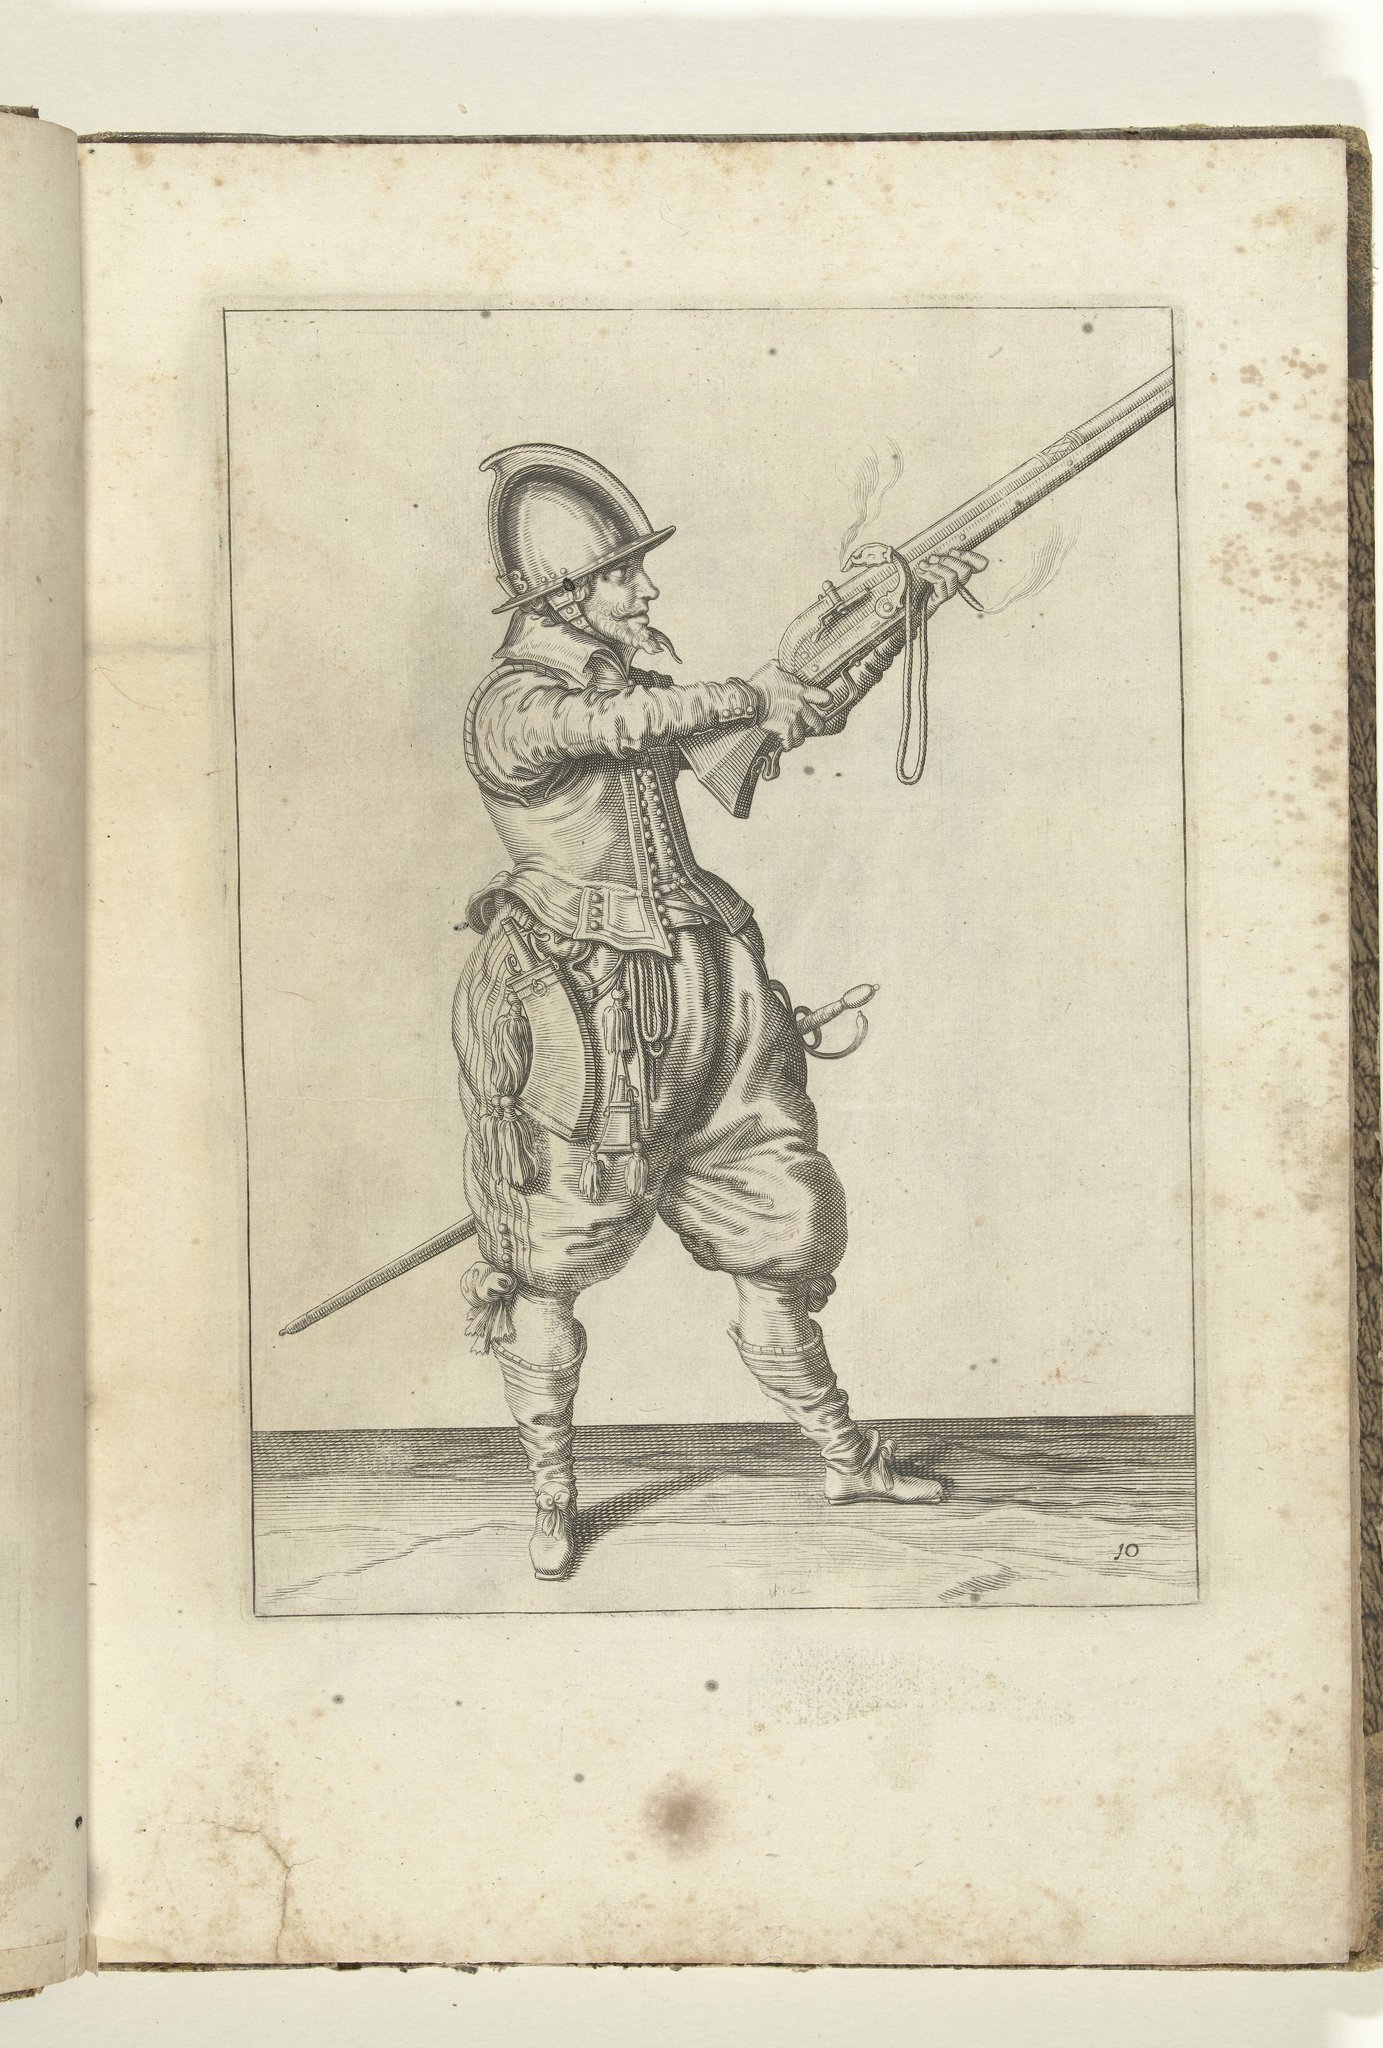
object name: print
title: Soldaat richt de roer met beide handen omhoog (nr. 10), ca. 1600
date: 1597-1608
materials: paper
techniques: engraving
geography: amsterdam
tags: maurice (prince of orange), handling of weapons ~ military training, weapons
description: Een soldaat, ten voeten uit, naar rechts, die een roer (een bepaald type vuurwapen) met beide handen vasthoudt en deze schuin omhoog richt (nr. 10), ca. 1600. Plaat 10 in de instructies voor het hanteren van de roer: Brief enseignement, sur la representation des figures, du droit maniement de l'Harquebuse. Onderdeel van de illustraties in een Franse editie van J. de Gheyns Wapenhandelinghe: J. de Gheyn, Maniement d'armes, d'arquebuses, mousquetz et piques : en conformité de l'ordre de Mour le Prince Maurice, Prince d'Orange, Amsterdam 1608. Krijgswezen rond 1600.